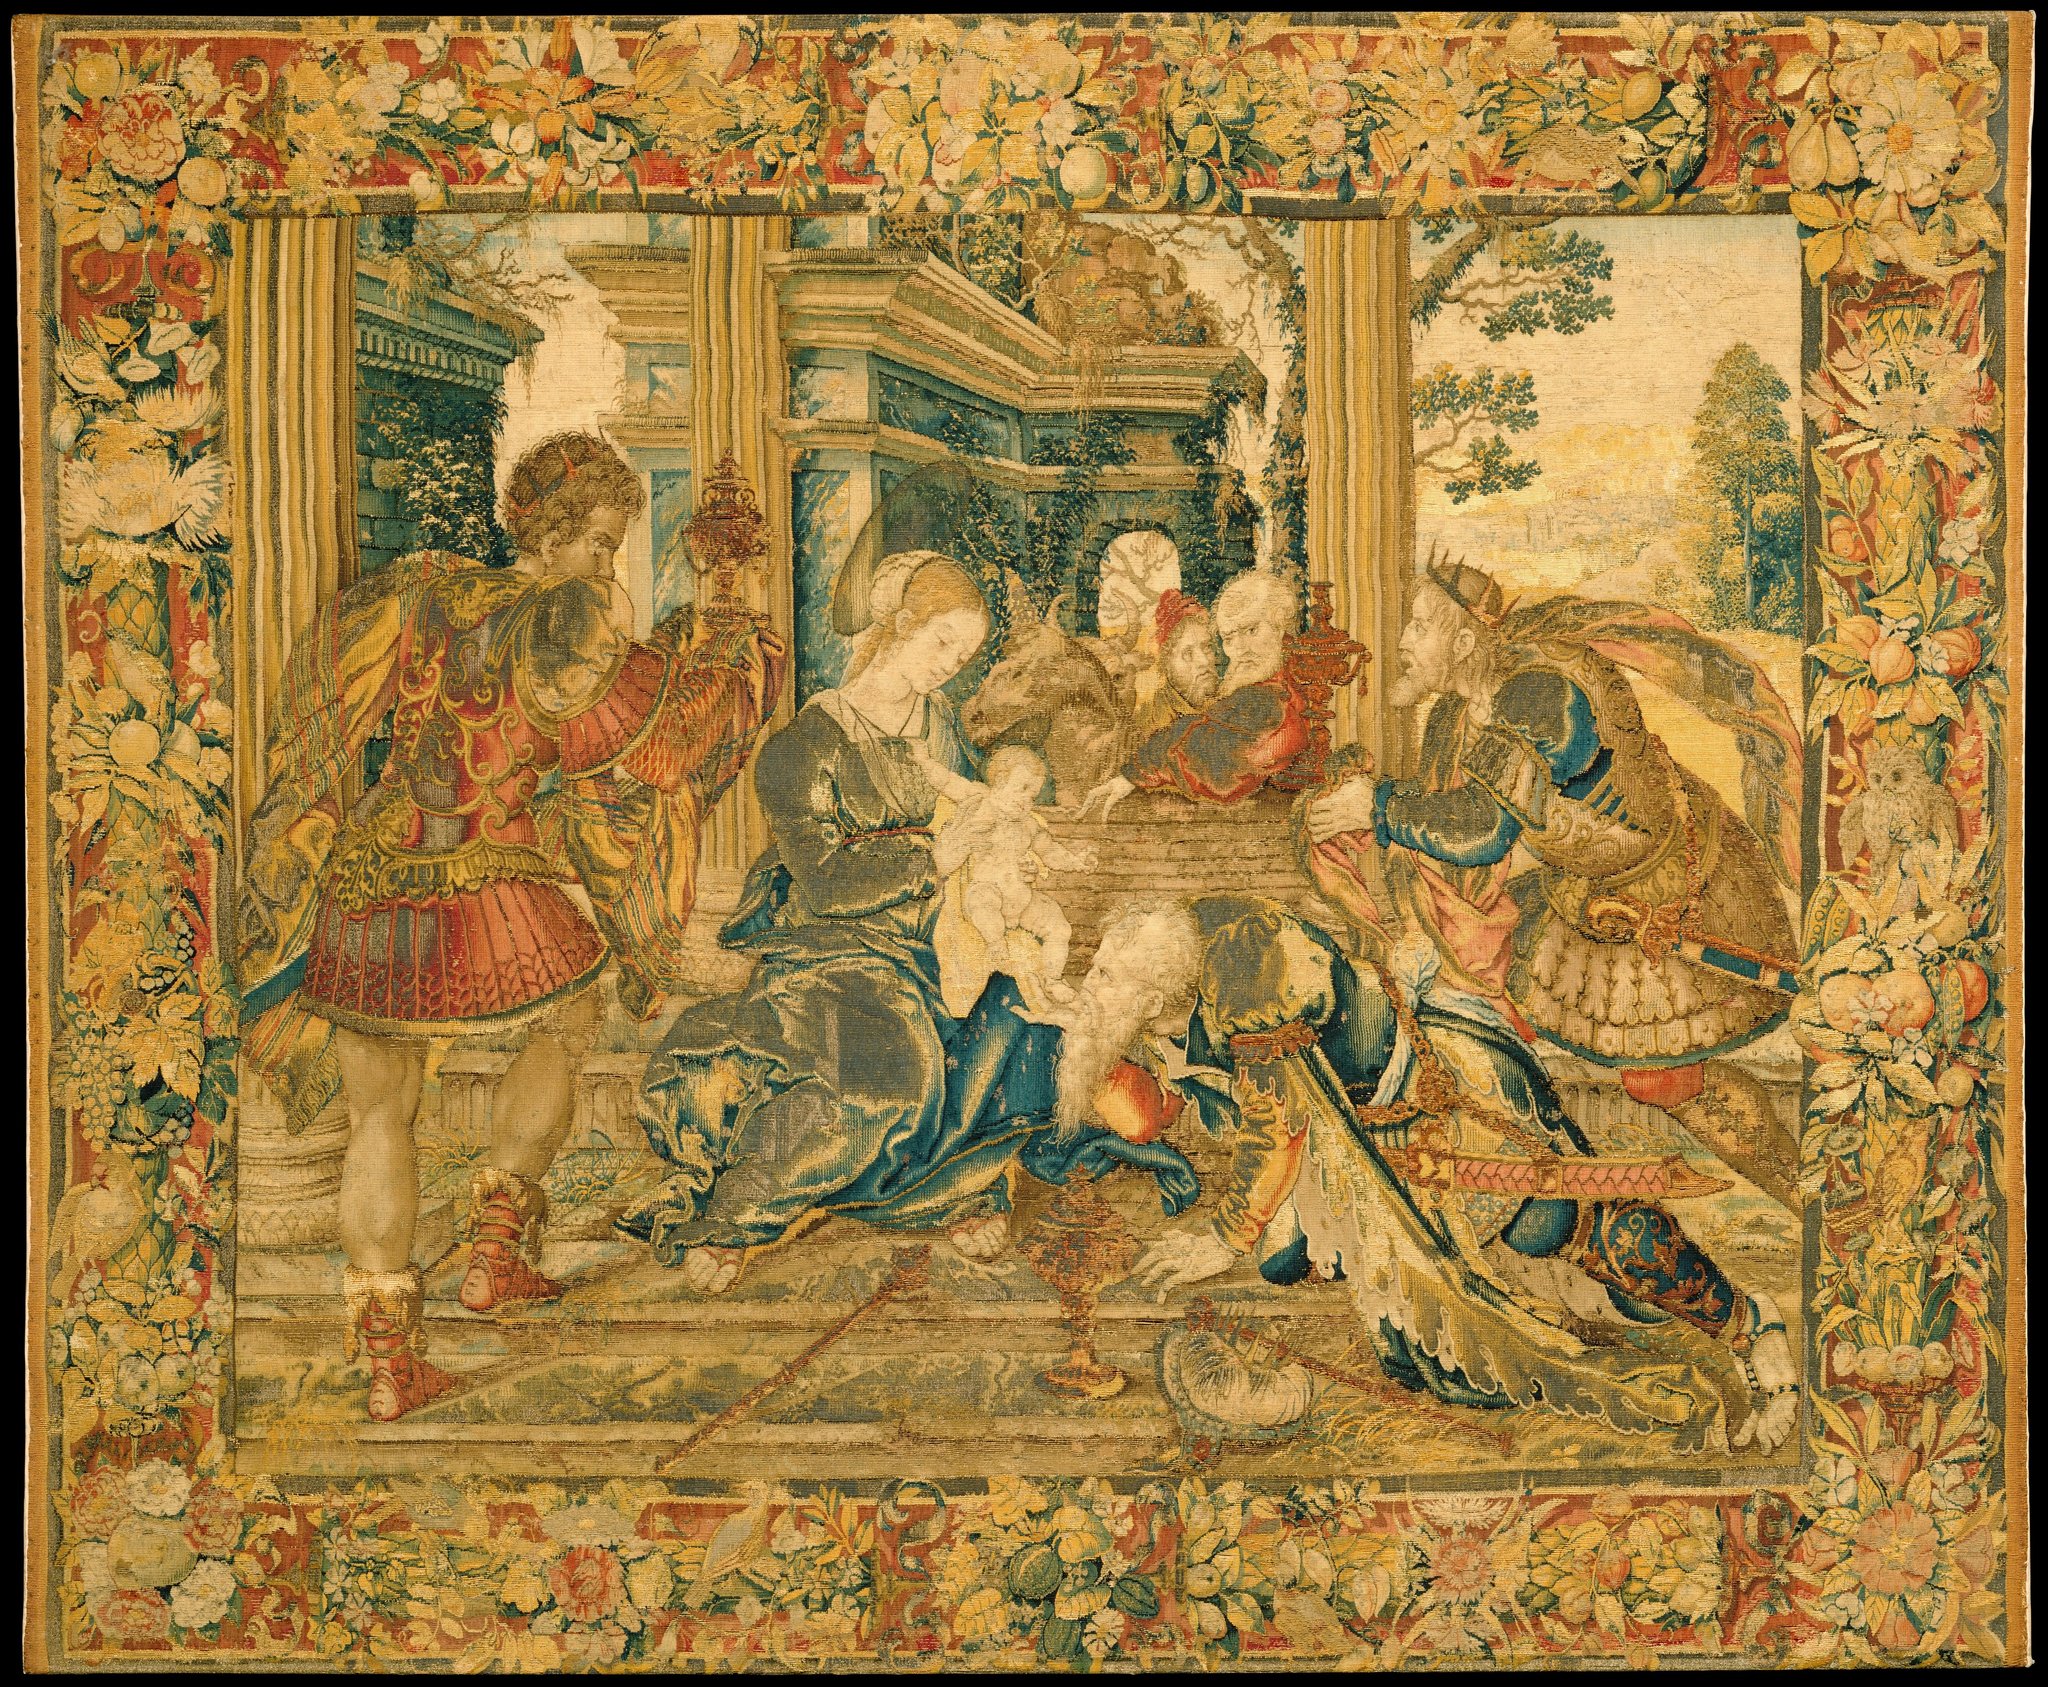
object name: tapestry and frame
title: Adoration of the Kings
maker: bernard van orley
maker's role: designer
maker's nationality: netherlandish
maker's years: 1492-1542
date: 1525-1535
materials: silk, silver, silver gilt, thread, wool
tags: animals,kings,infants,women